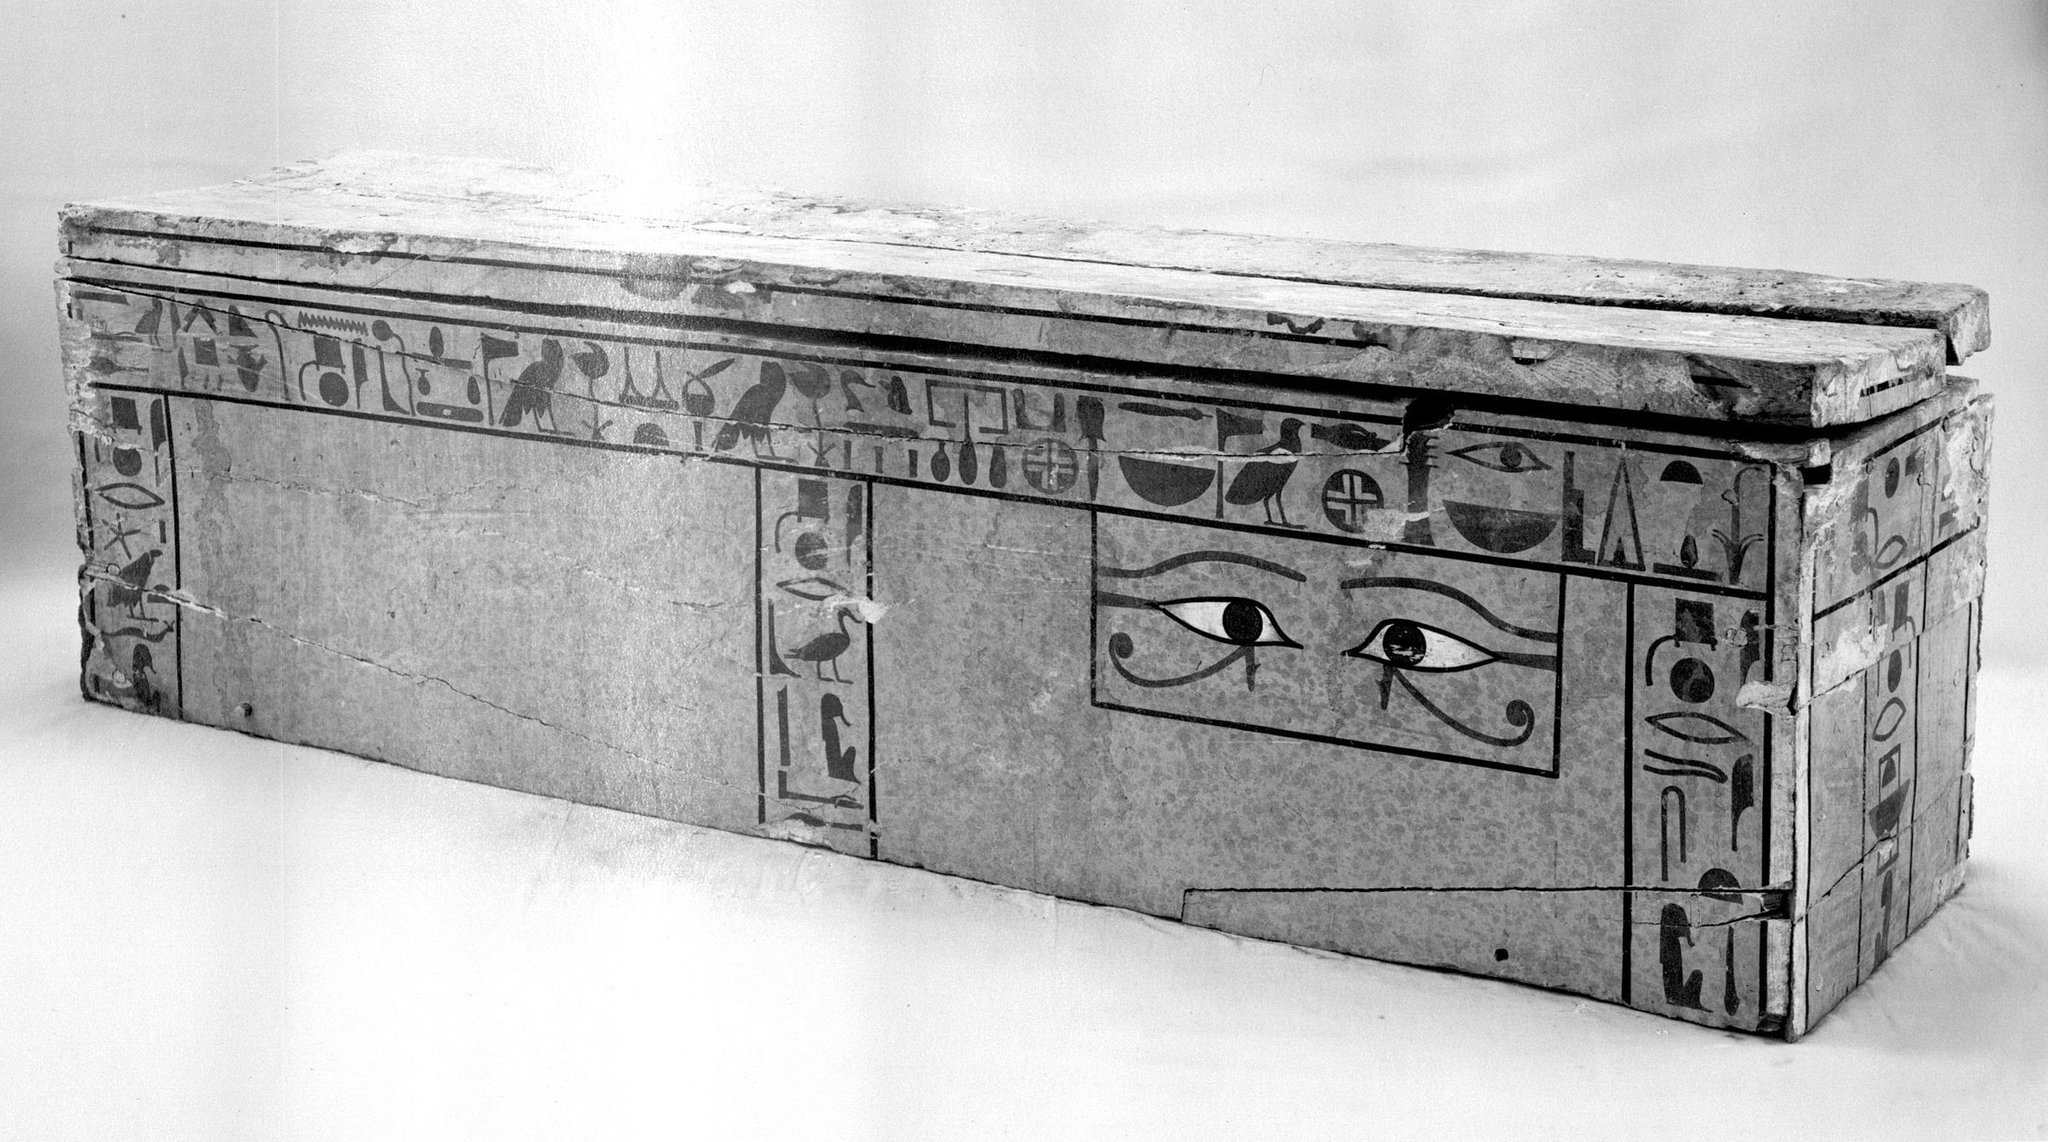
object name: coffin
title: Coffin of Hekaib-Hapy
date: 1640-1550 BCE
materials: wood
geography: egypt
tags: hieroglyphs,coffins